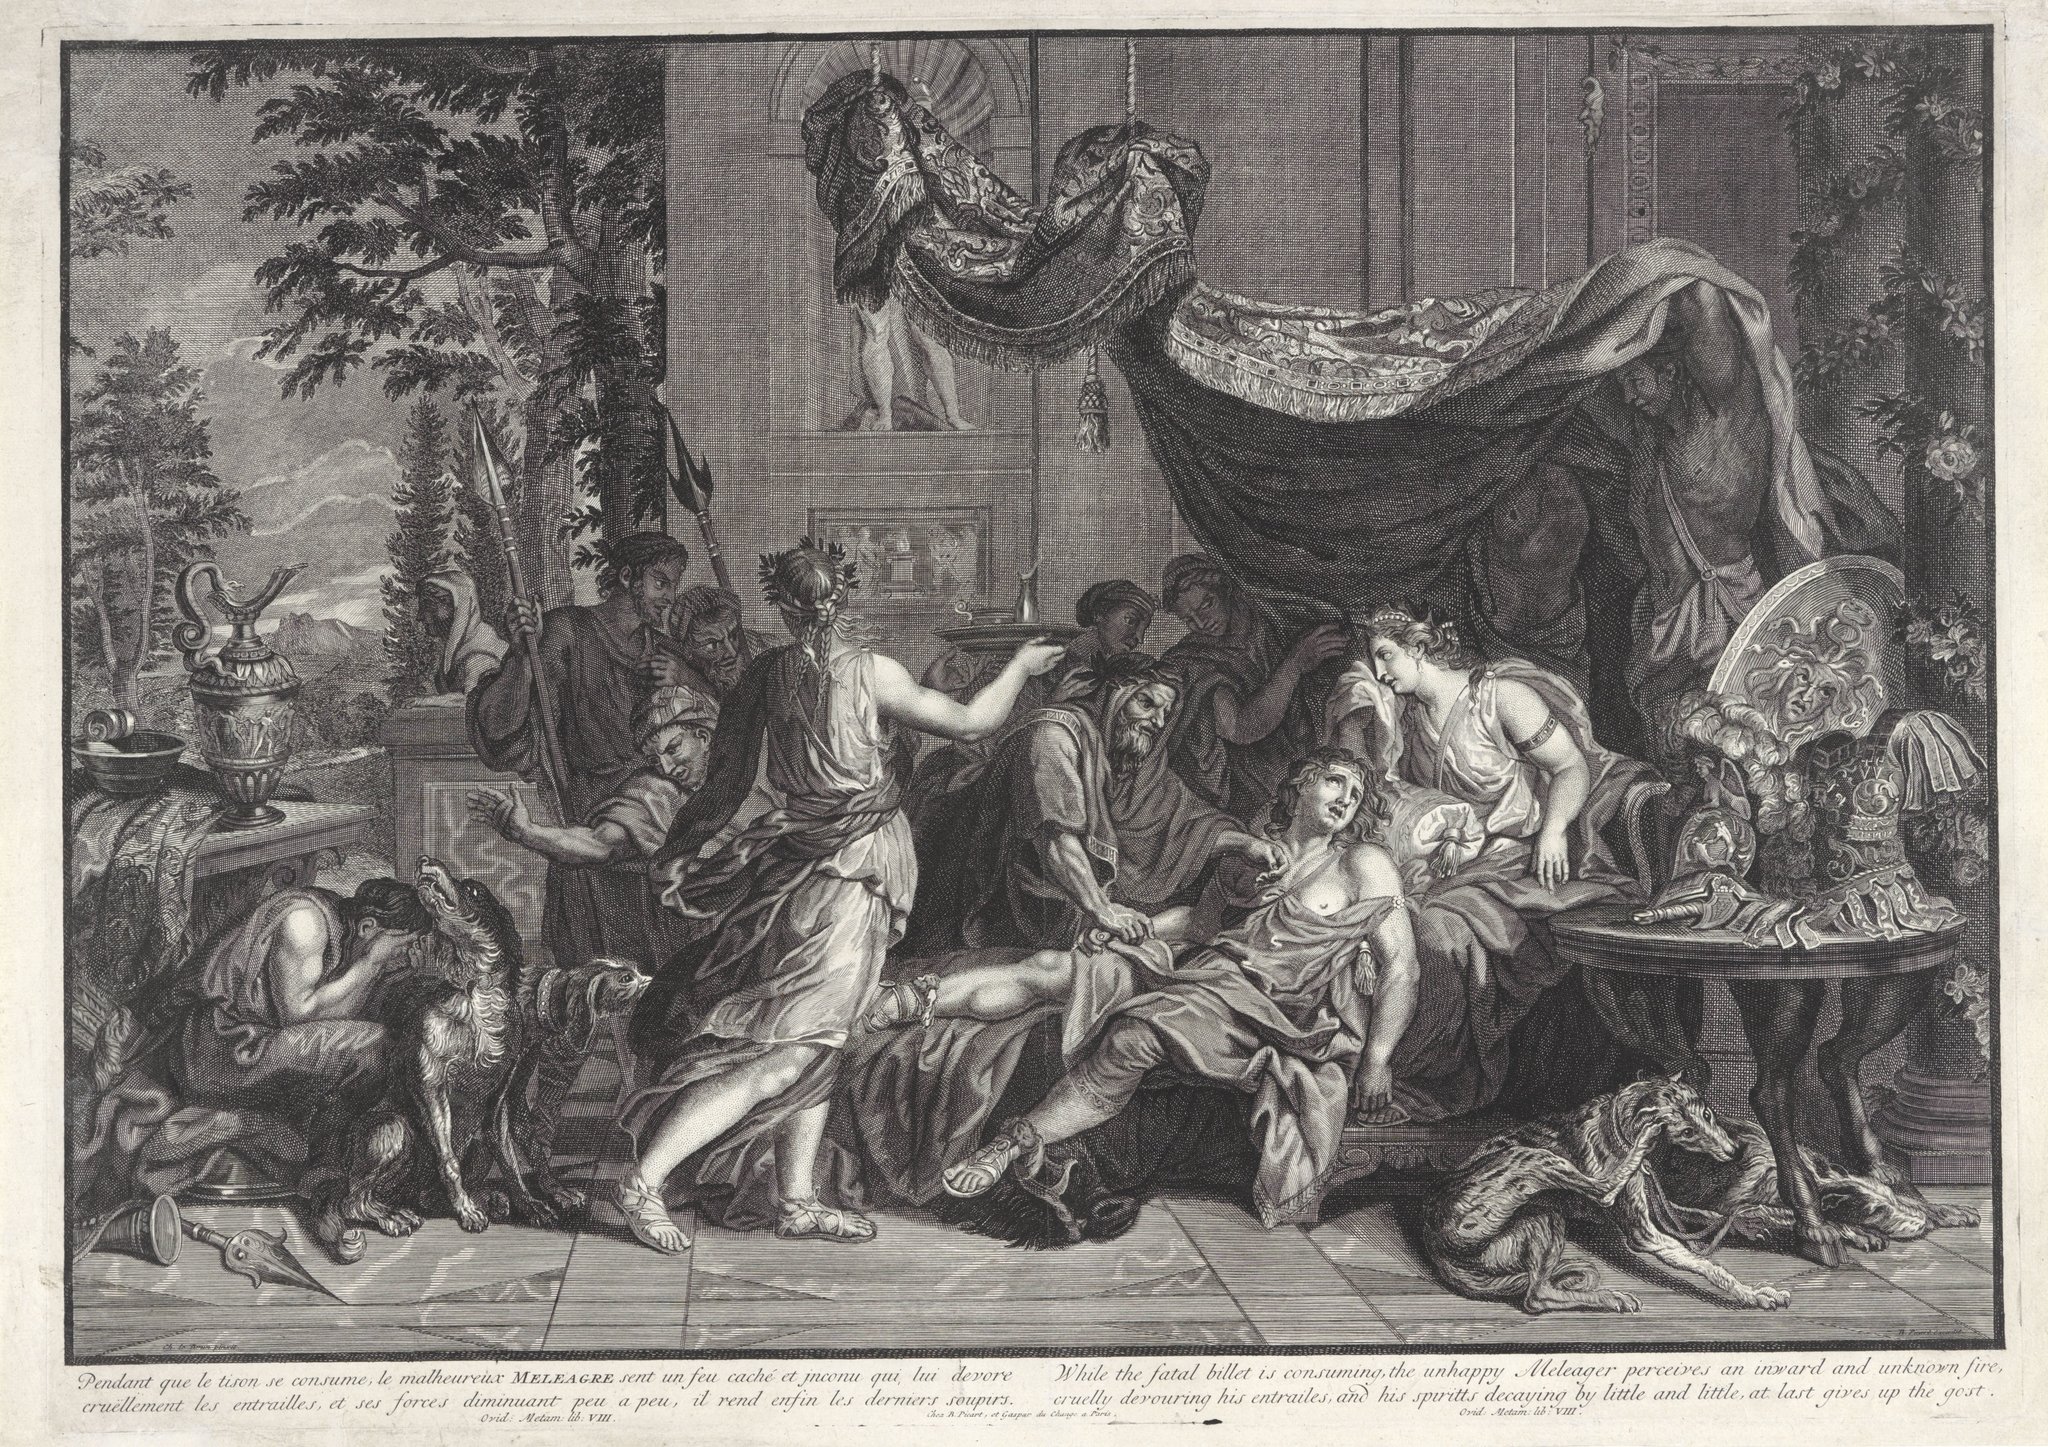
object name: print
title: Geschiedenis van Meleager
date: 1683-1710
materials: paper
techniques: engraving, etching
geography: paris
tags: death of meleager: althaea throws the unburnt brand into the fire, thus causing meleager's death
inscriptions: collector's mark: Lugt 2228, collector's mark: Lugt 2233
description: Als het houtblok, dat met het leven van Meleager is verbonden, wordt verteerd in het vuur, kwijnt Meleager weg en sterft. Hij ligt bij zijn geliefde Atalanta op schoot, terwijl hij sterft. Bedienden snellen toe. Onder de voorstelling een verklarende tekst in het Frans en het Engels.